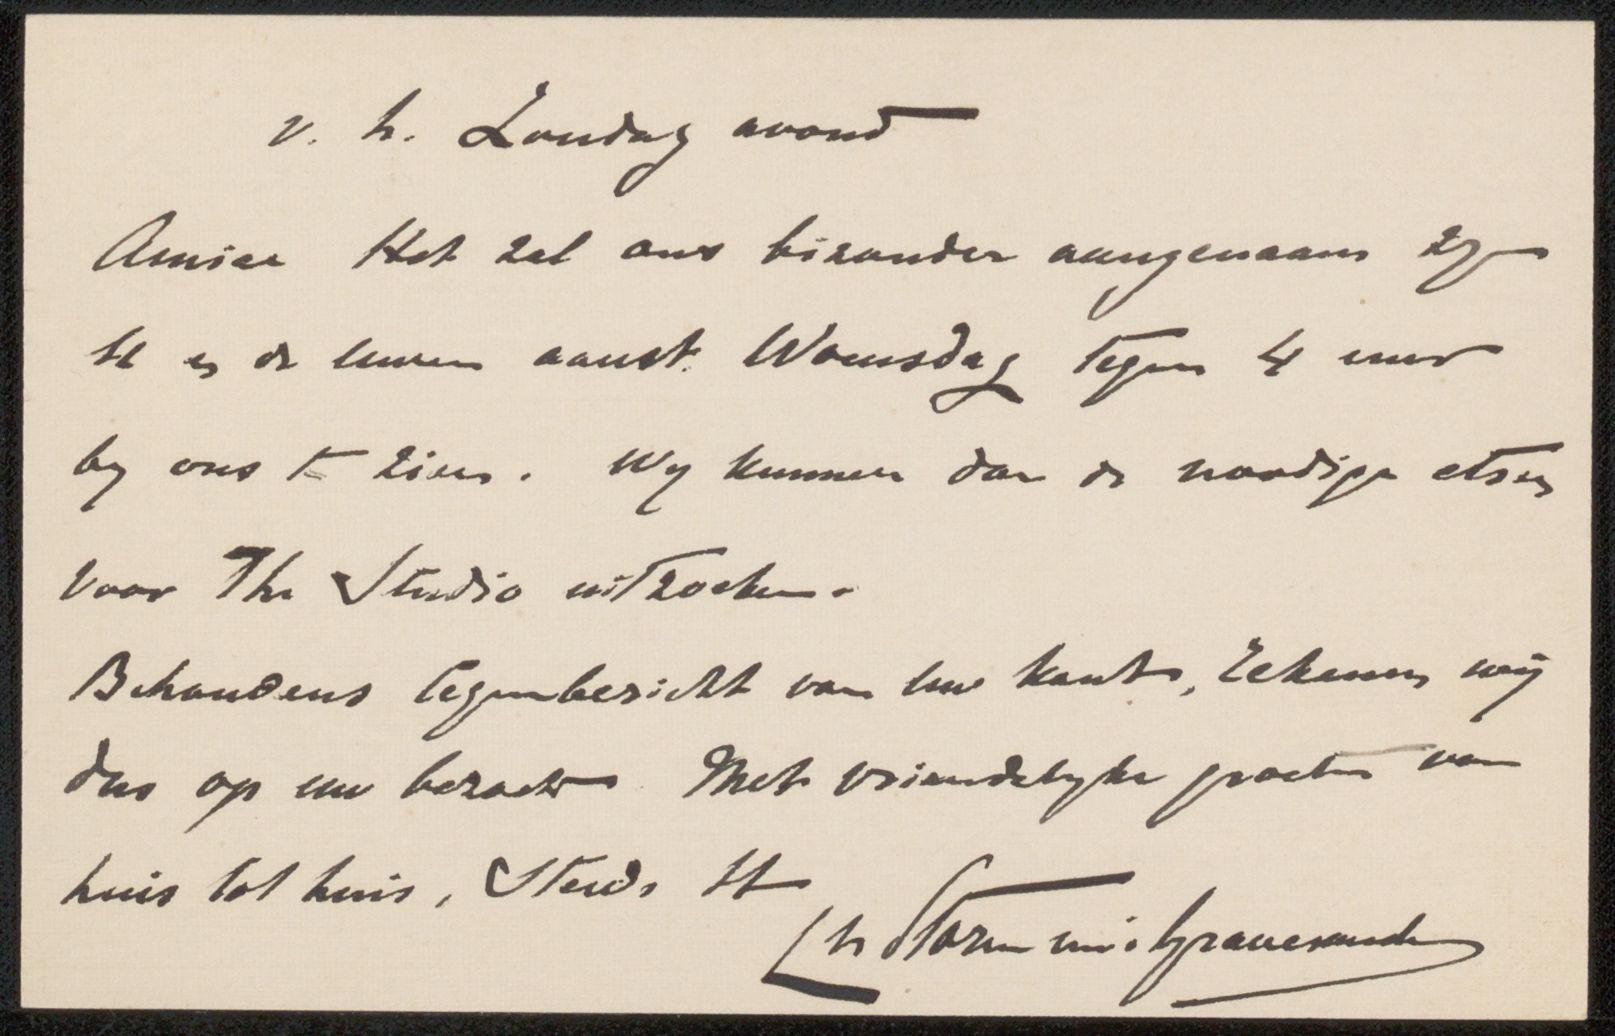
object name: letter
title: Brief aan Philip Zilcken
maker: carel nicolaas storm van s-gravesande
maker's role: draughtsman, print maker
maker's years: 1841-1924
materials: cardboard, ink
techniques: pen, writing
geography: the hague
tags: painter, philip zilcken, the graphic arts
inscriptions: collector's mark: ‘RPK’